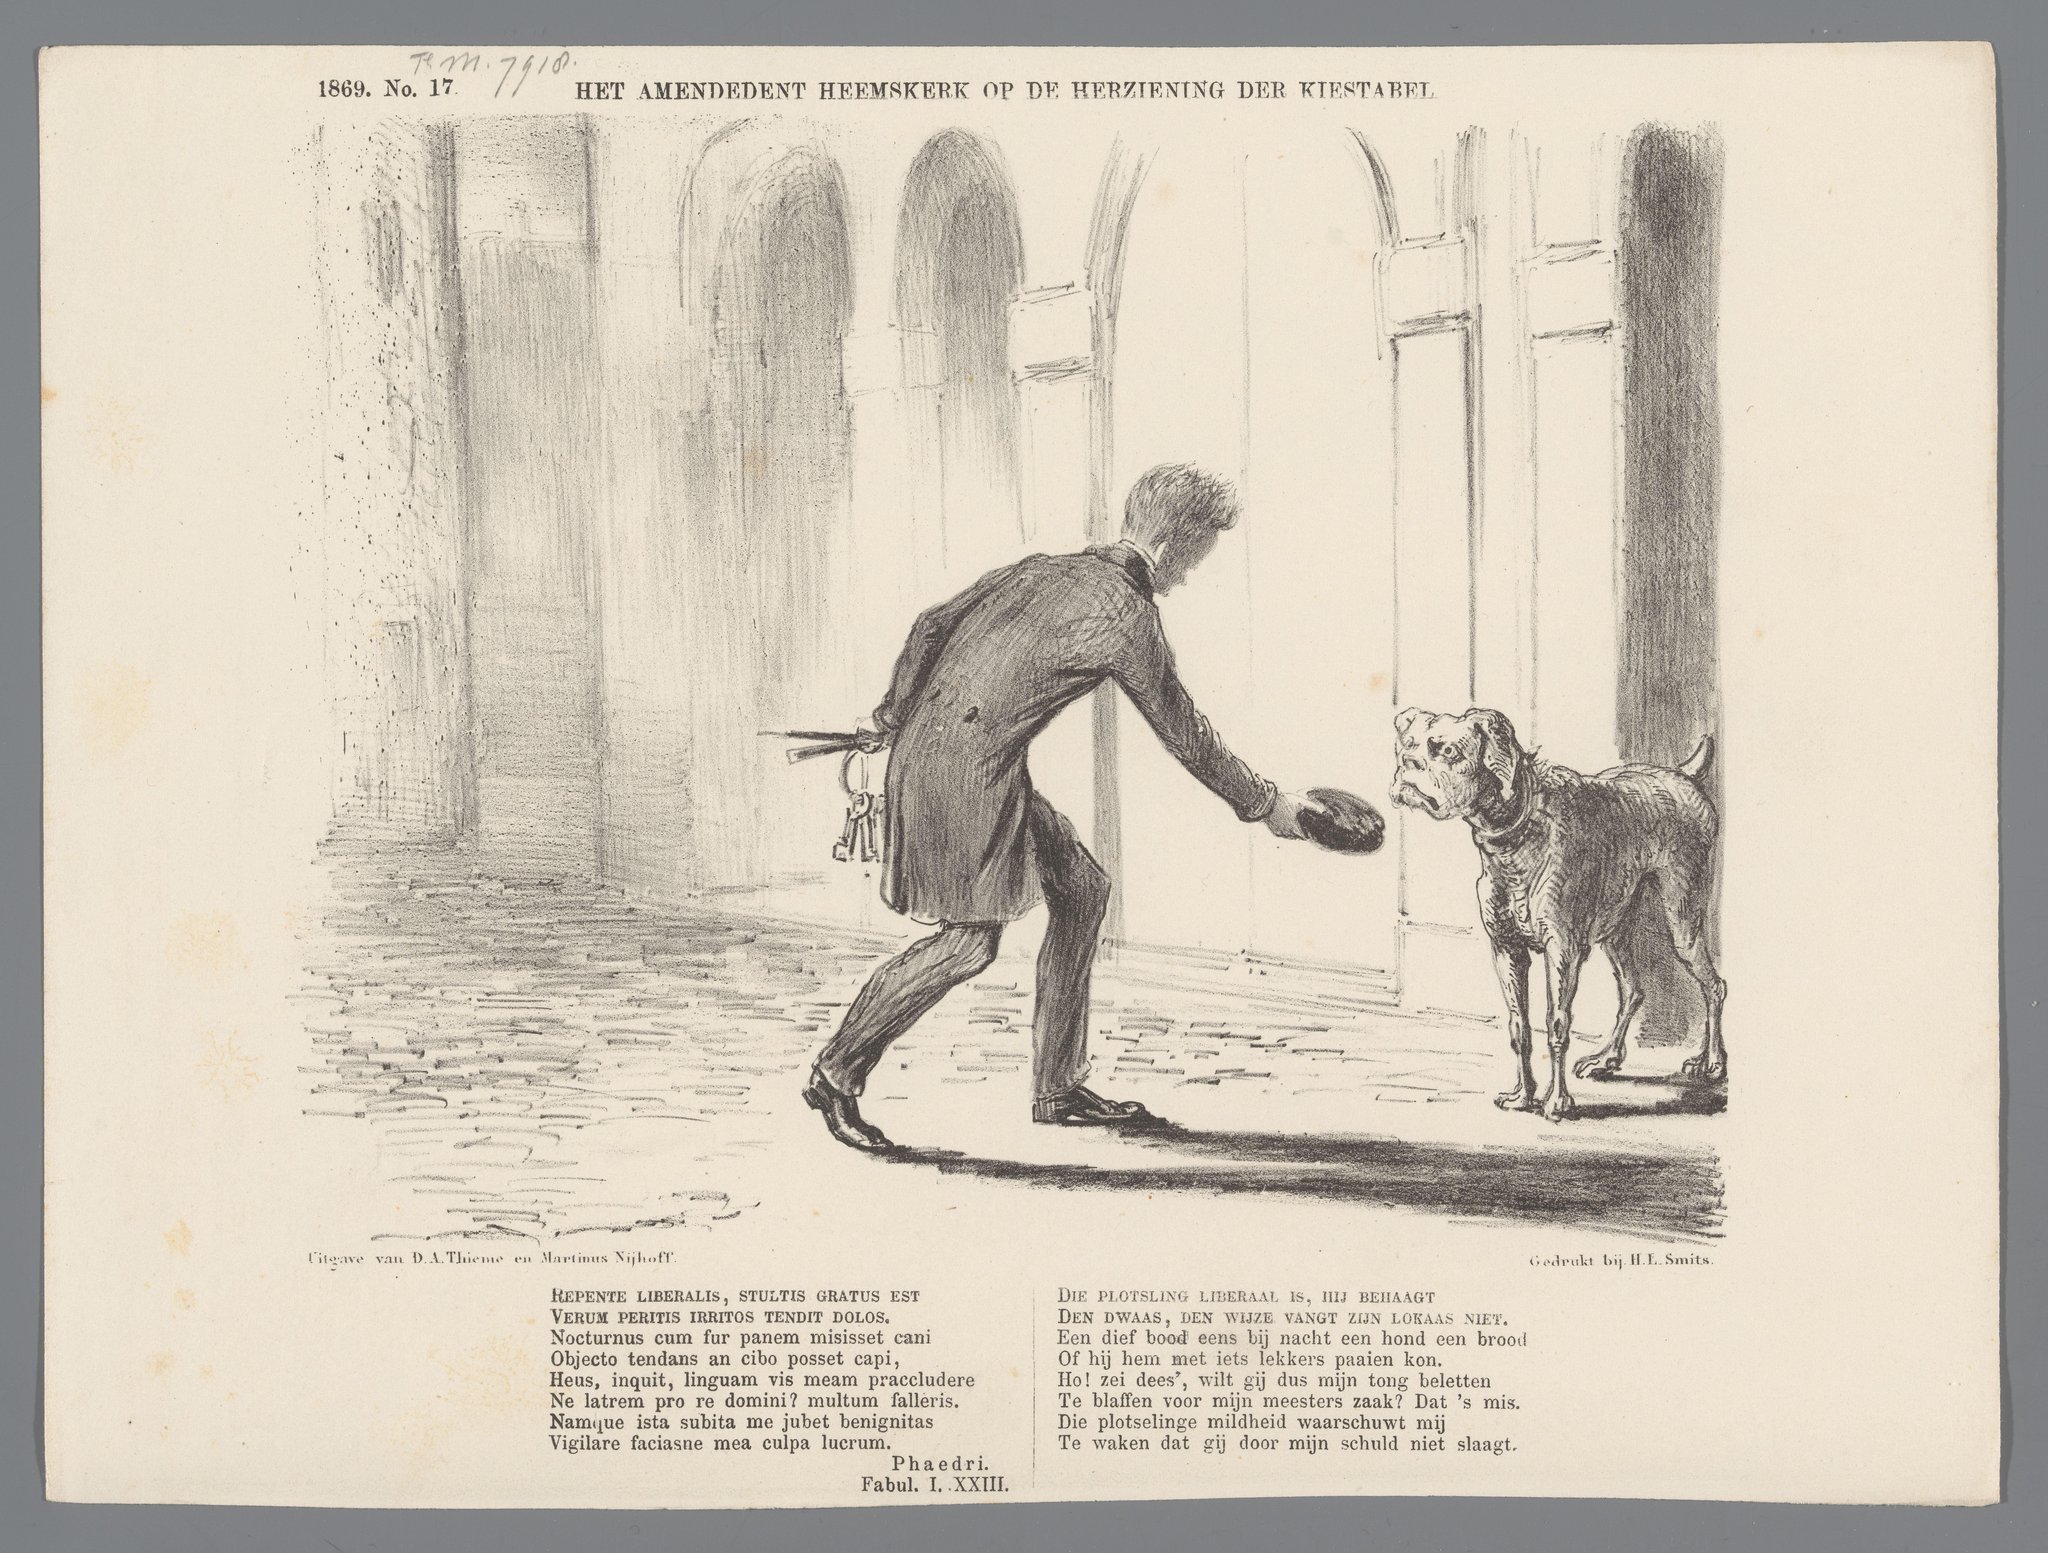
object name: cartoon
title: Spotprent op het amendement van Heemskerk, 1869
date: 1869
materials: paper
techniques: lithograph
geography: netherlands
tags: amsterdam, the hague, politician, watch-dog, dog watching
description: Spotprent op de voorgewende vrijzinnigheid van het amendement van Heemskerk. Heemskerk als inbreker die een waakhond probeert te voeren. Plaat verschenen bij het weekblad De Nederlandsche Spectator, nr. 17, 1869.